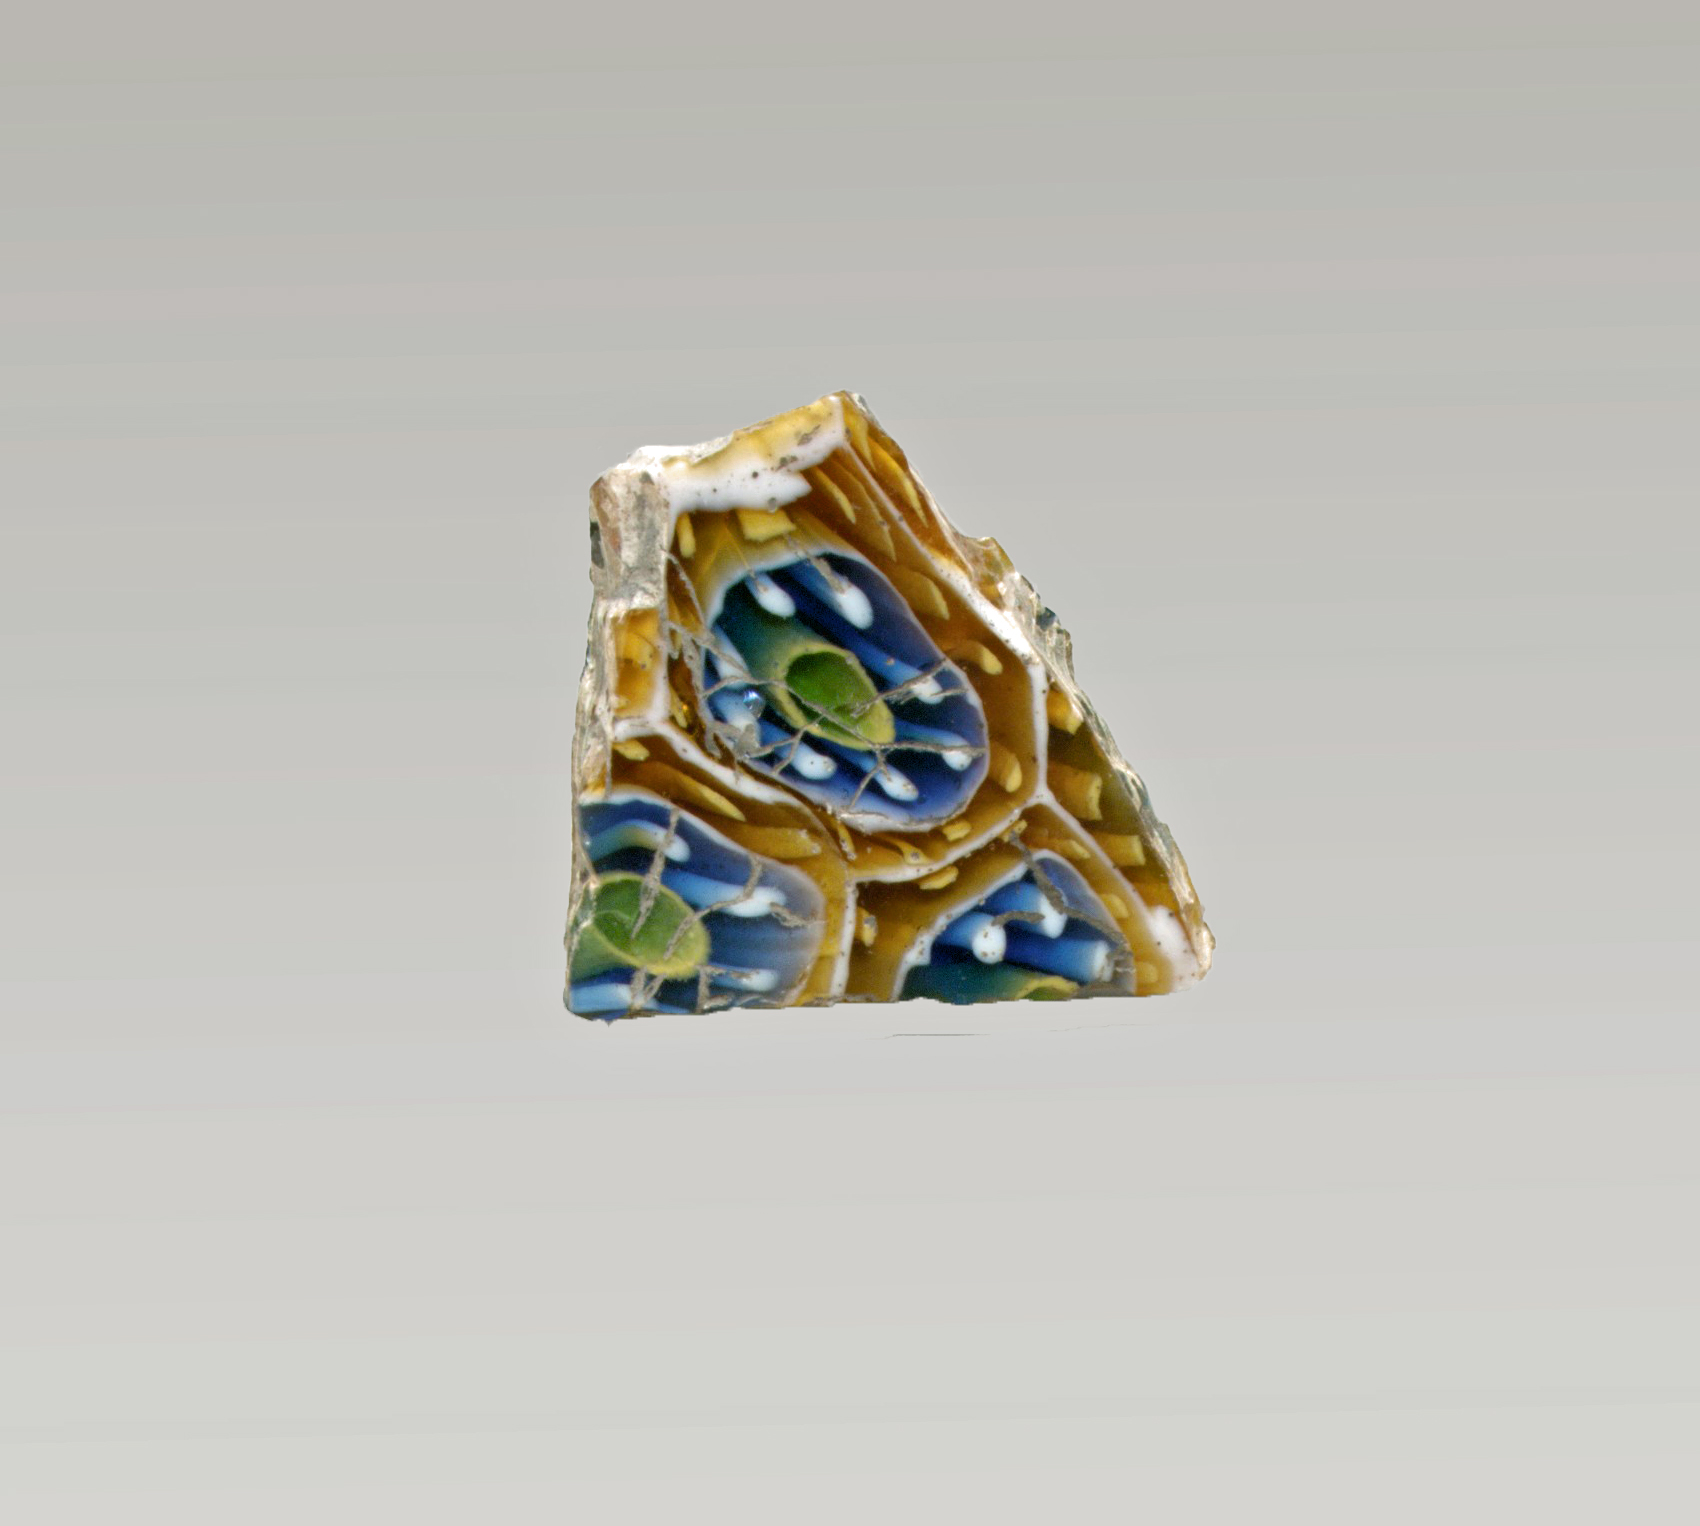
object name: fragment, mosaic bowl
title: Glass mosaic ribbed bowl fragment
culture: roman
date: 34 BCE-33 CE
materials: glass